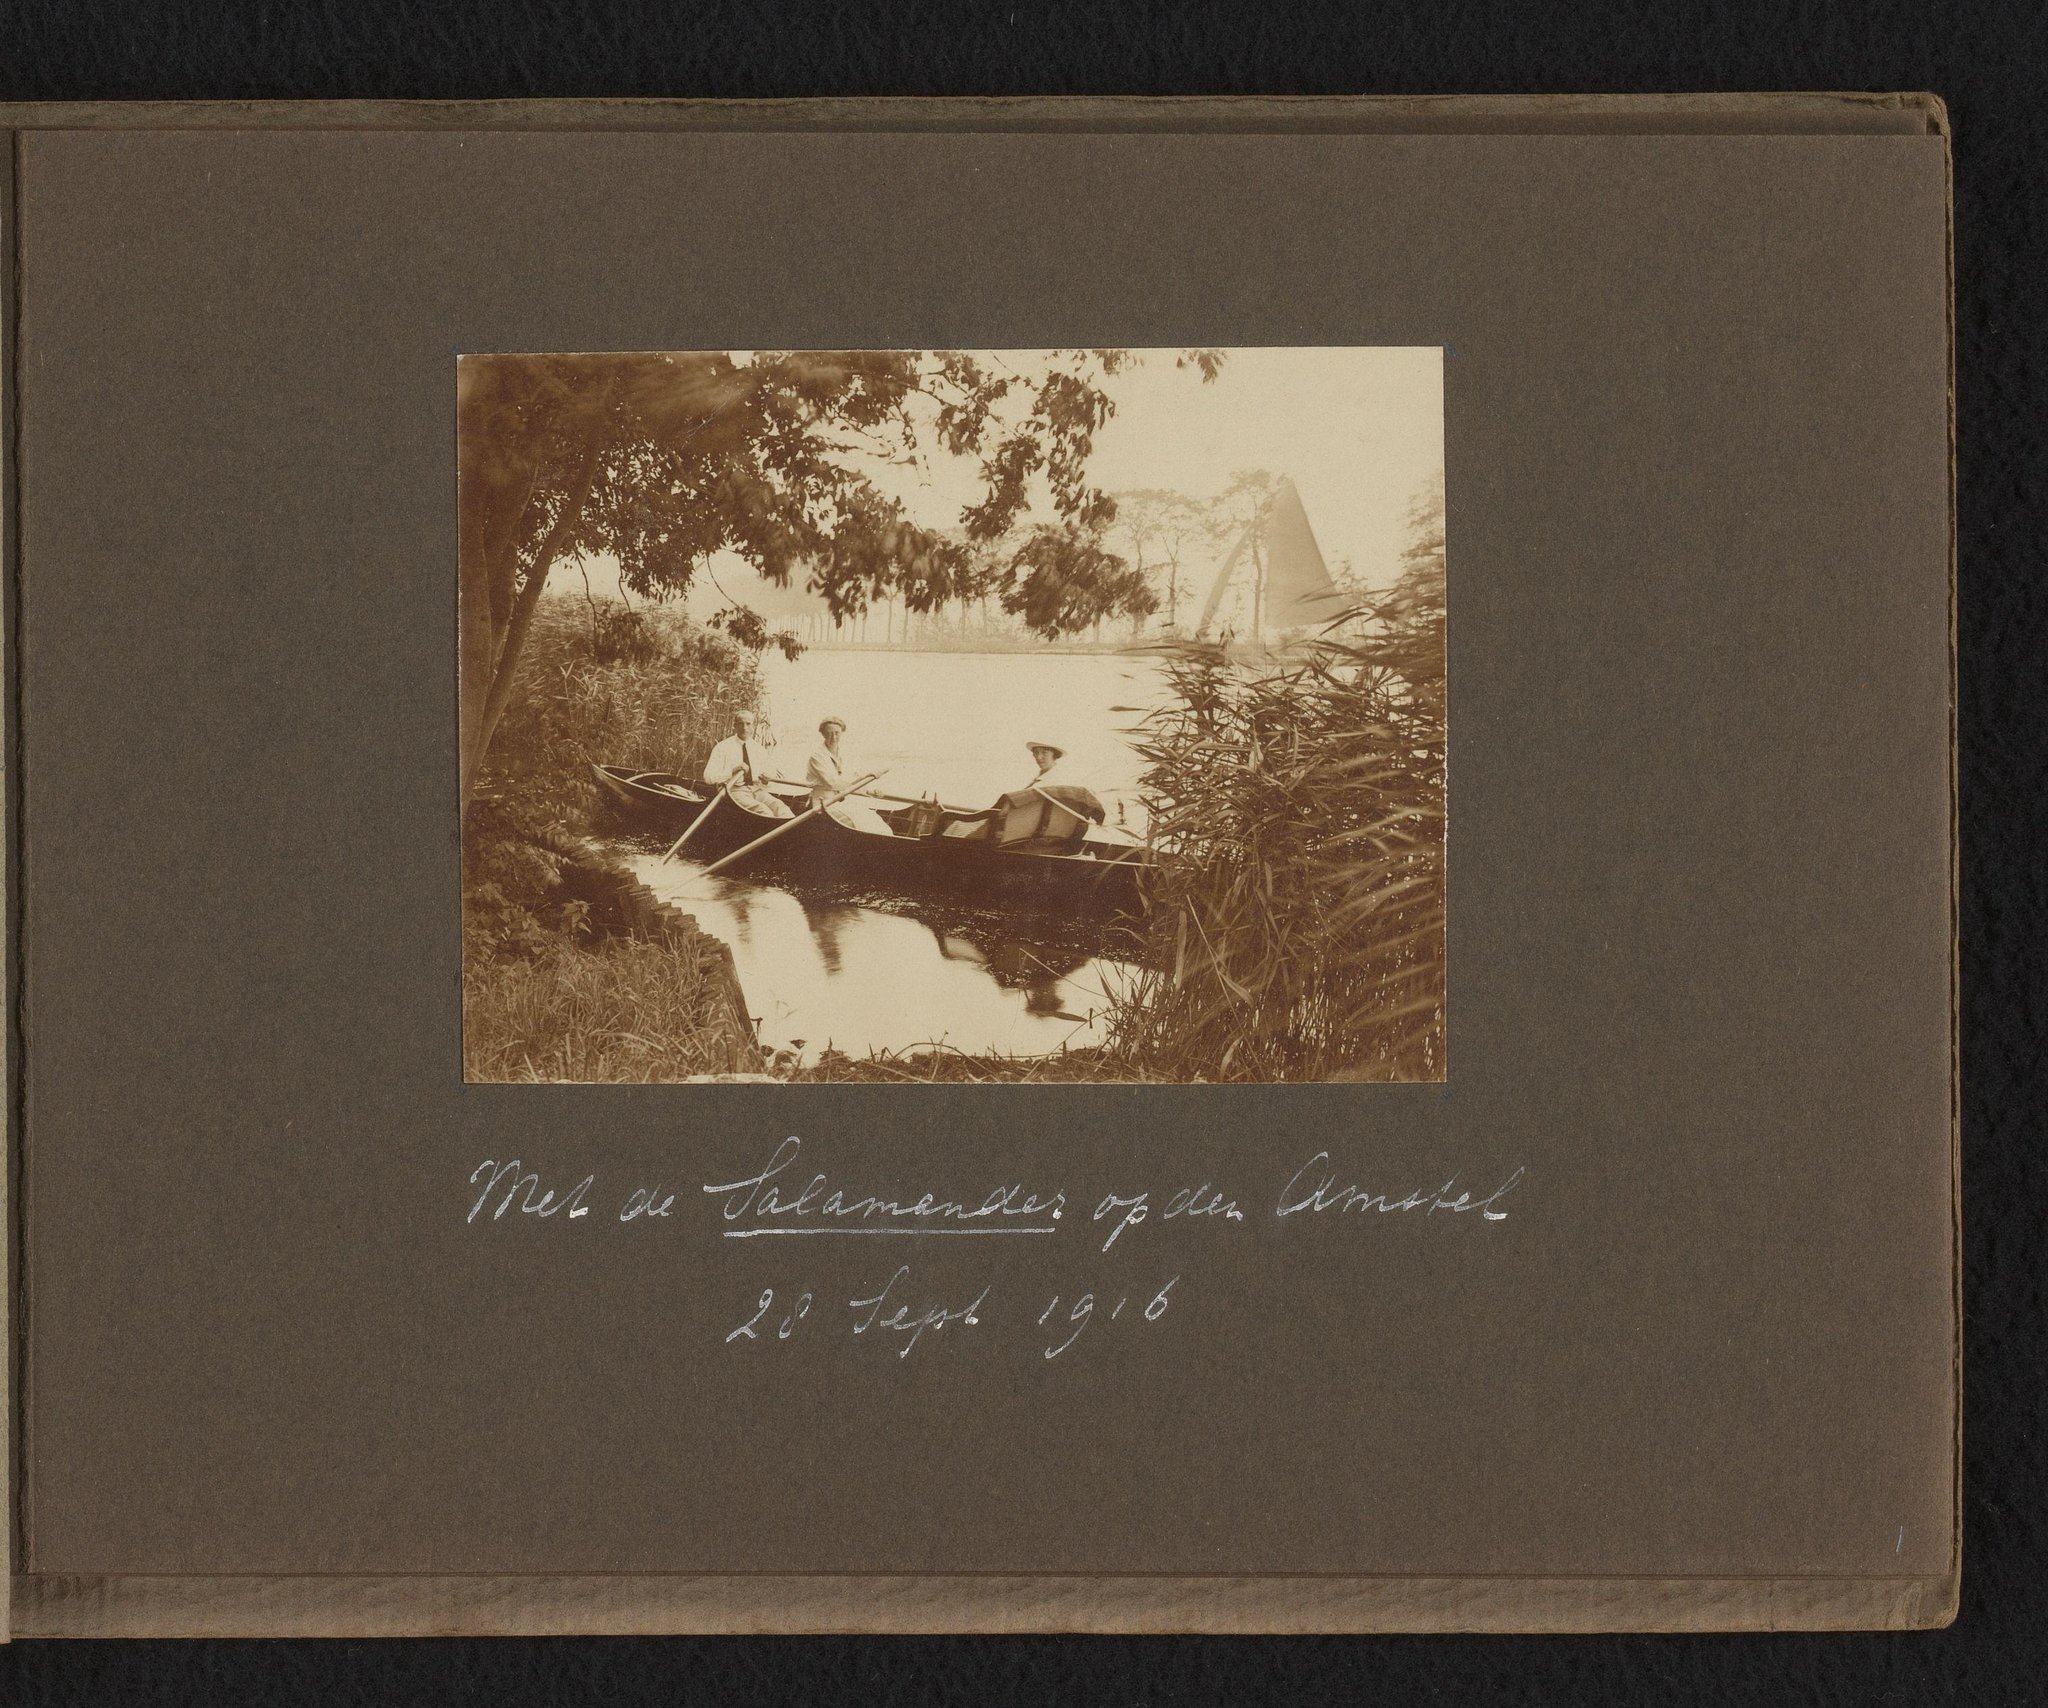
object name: album leaf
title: Drie personen in een roeiboot op de Amstel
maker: Anonymous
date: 1916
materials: paper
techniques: matte daylight collodion silver print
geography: amstel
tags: river, rowing-boat, canoe, etc.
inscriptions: caption: ‘Met de Salamander op den Amstel’